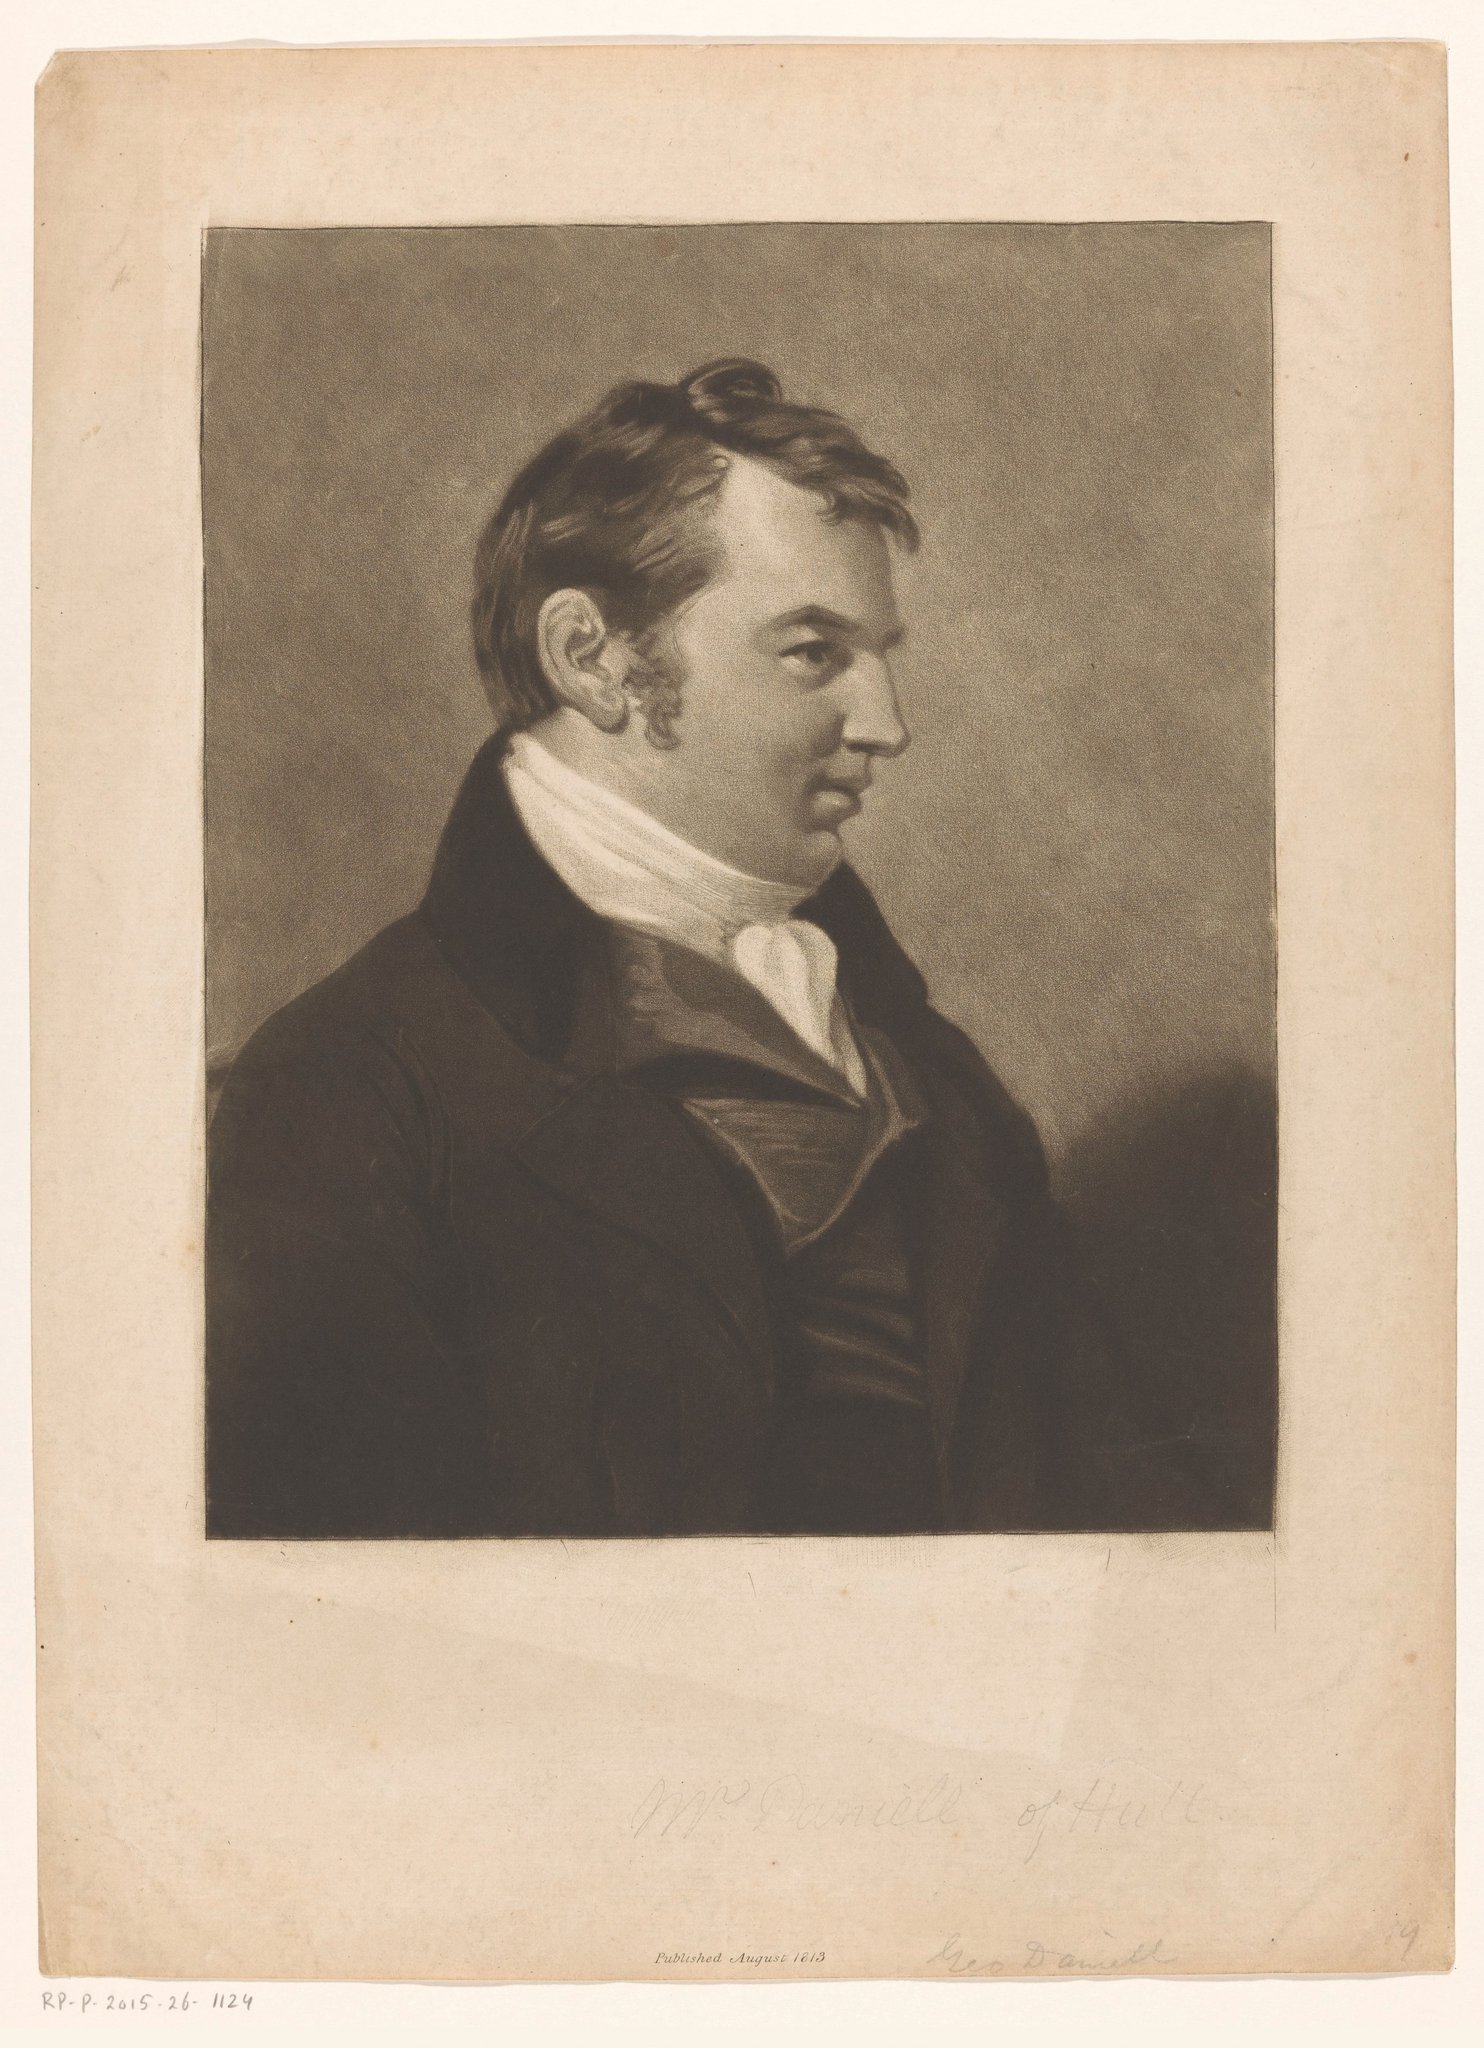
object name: print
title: Portret van George Daniell, boekverkoper te Hull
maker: Anonymous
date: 1808-1813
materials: paper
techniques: mezzotint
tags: book-shop, bookseller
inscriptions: annotation: ‘Mr. Daniell of Hull/ Geo Daniell’, collector's mark: Lugt 2228, annotation: ‘Mr Daniell of Hull / George Daniell, bookseller of Hull, one of proprietors of "Hull Advertiser" died 1807’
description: Identificatie van de voorgestelde persoon is gebaseerd op de notities op de prent.